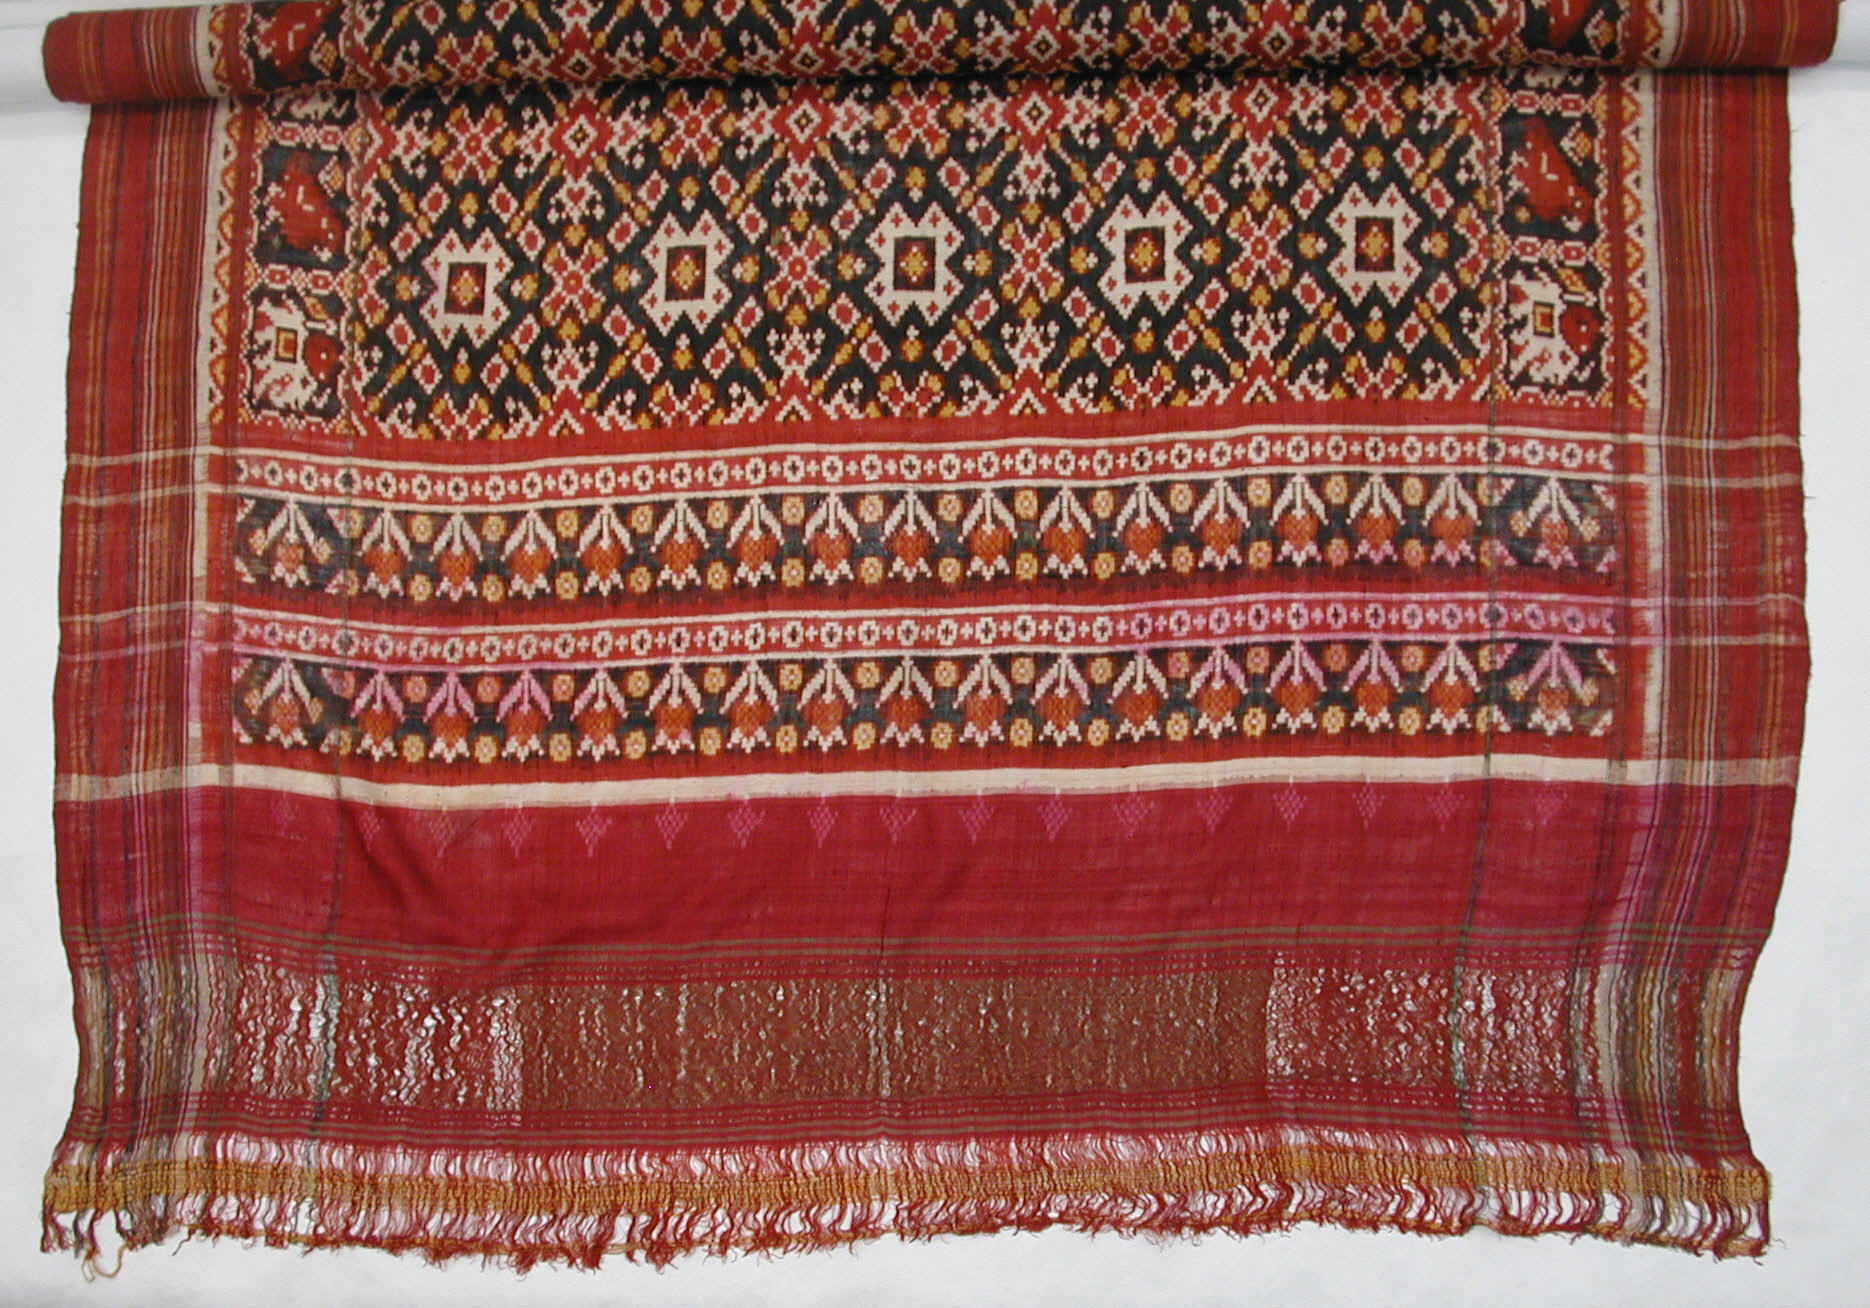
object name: sari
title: Wedding Sari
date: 1701-1900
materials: silk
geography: india